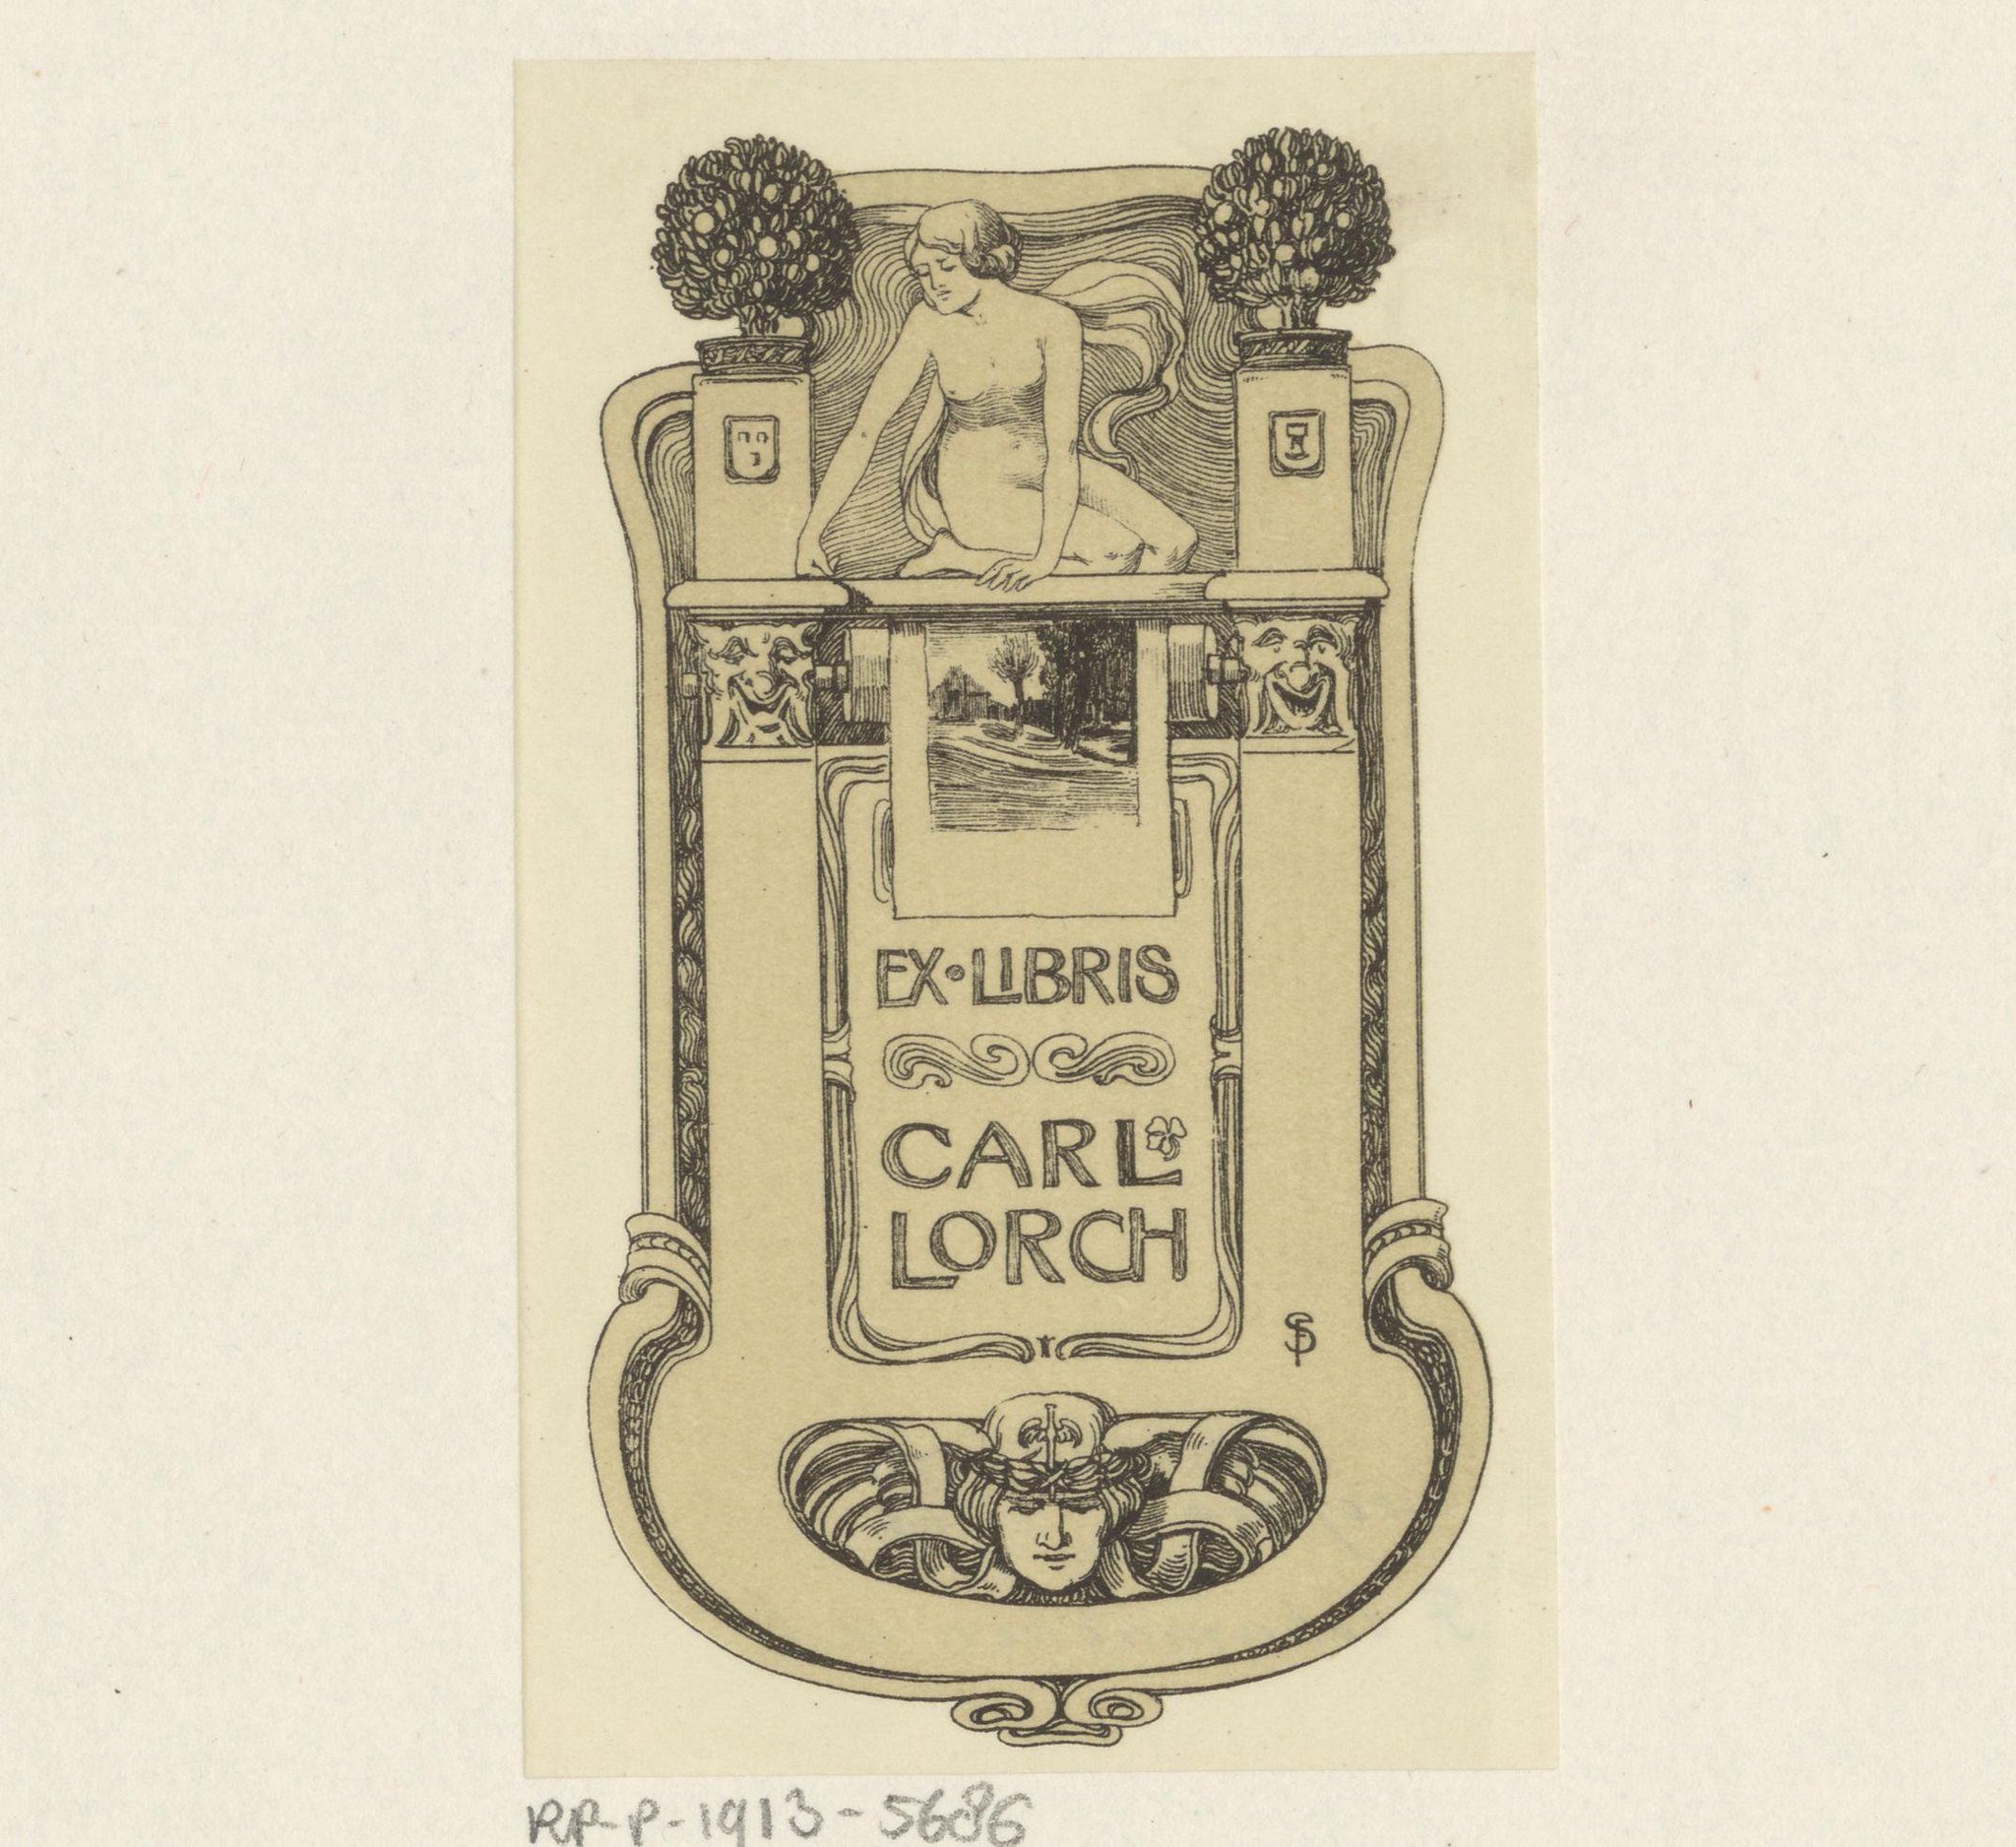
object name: bookplate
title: Ex libris van Carl Lorch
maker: fritz schumacher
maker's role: print maker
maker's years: 1869-1947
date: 1900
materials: paper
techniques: lithograph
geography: germany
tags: trees, landscapes, woman (showing herself) undressed, quasi-nude, head (human) - aa - female human figure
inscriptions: collector's mark: Lugt 2233, collector's mark: Lugt 2760